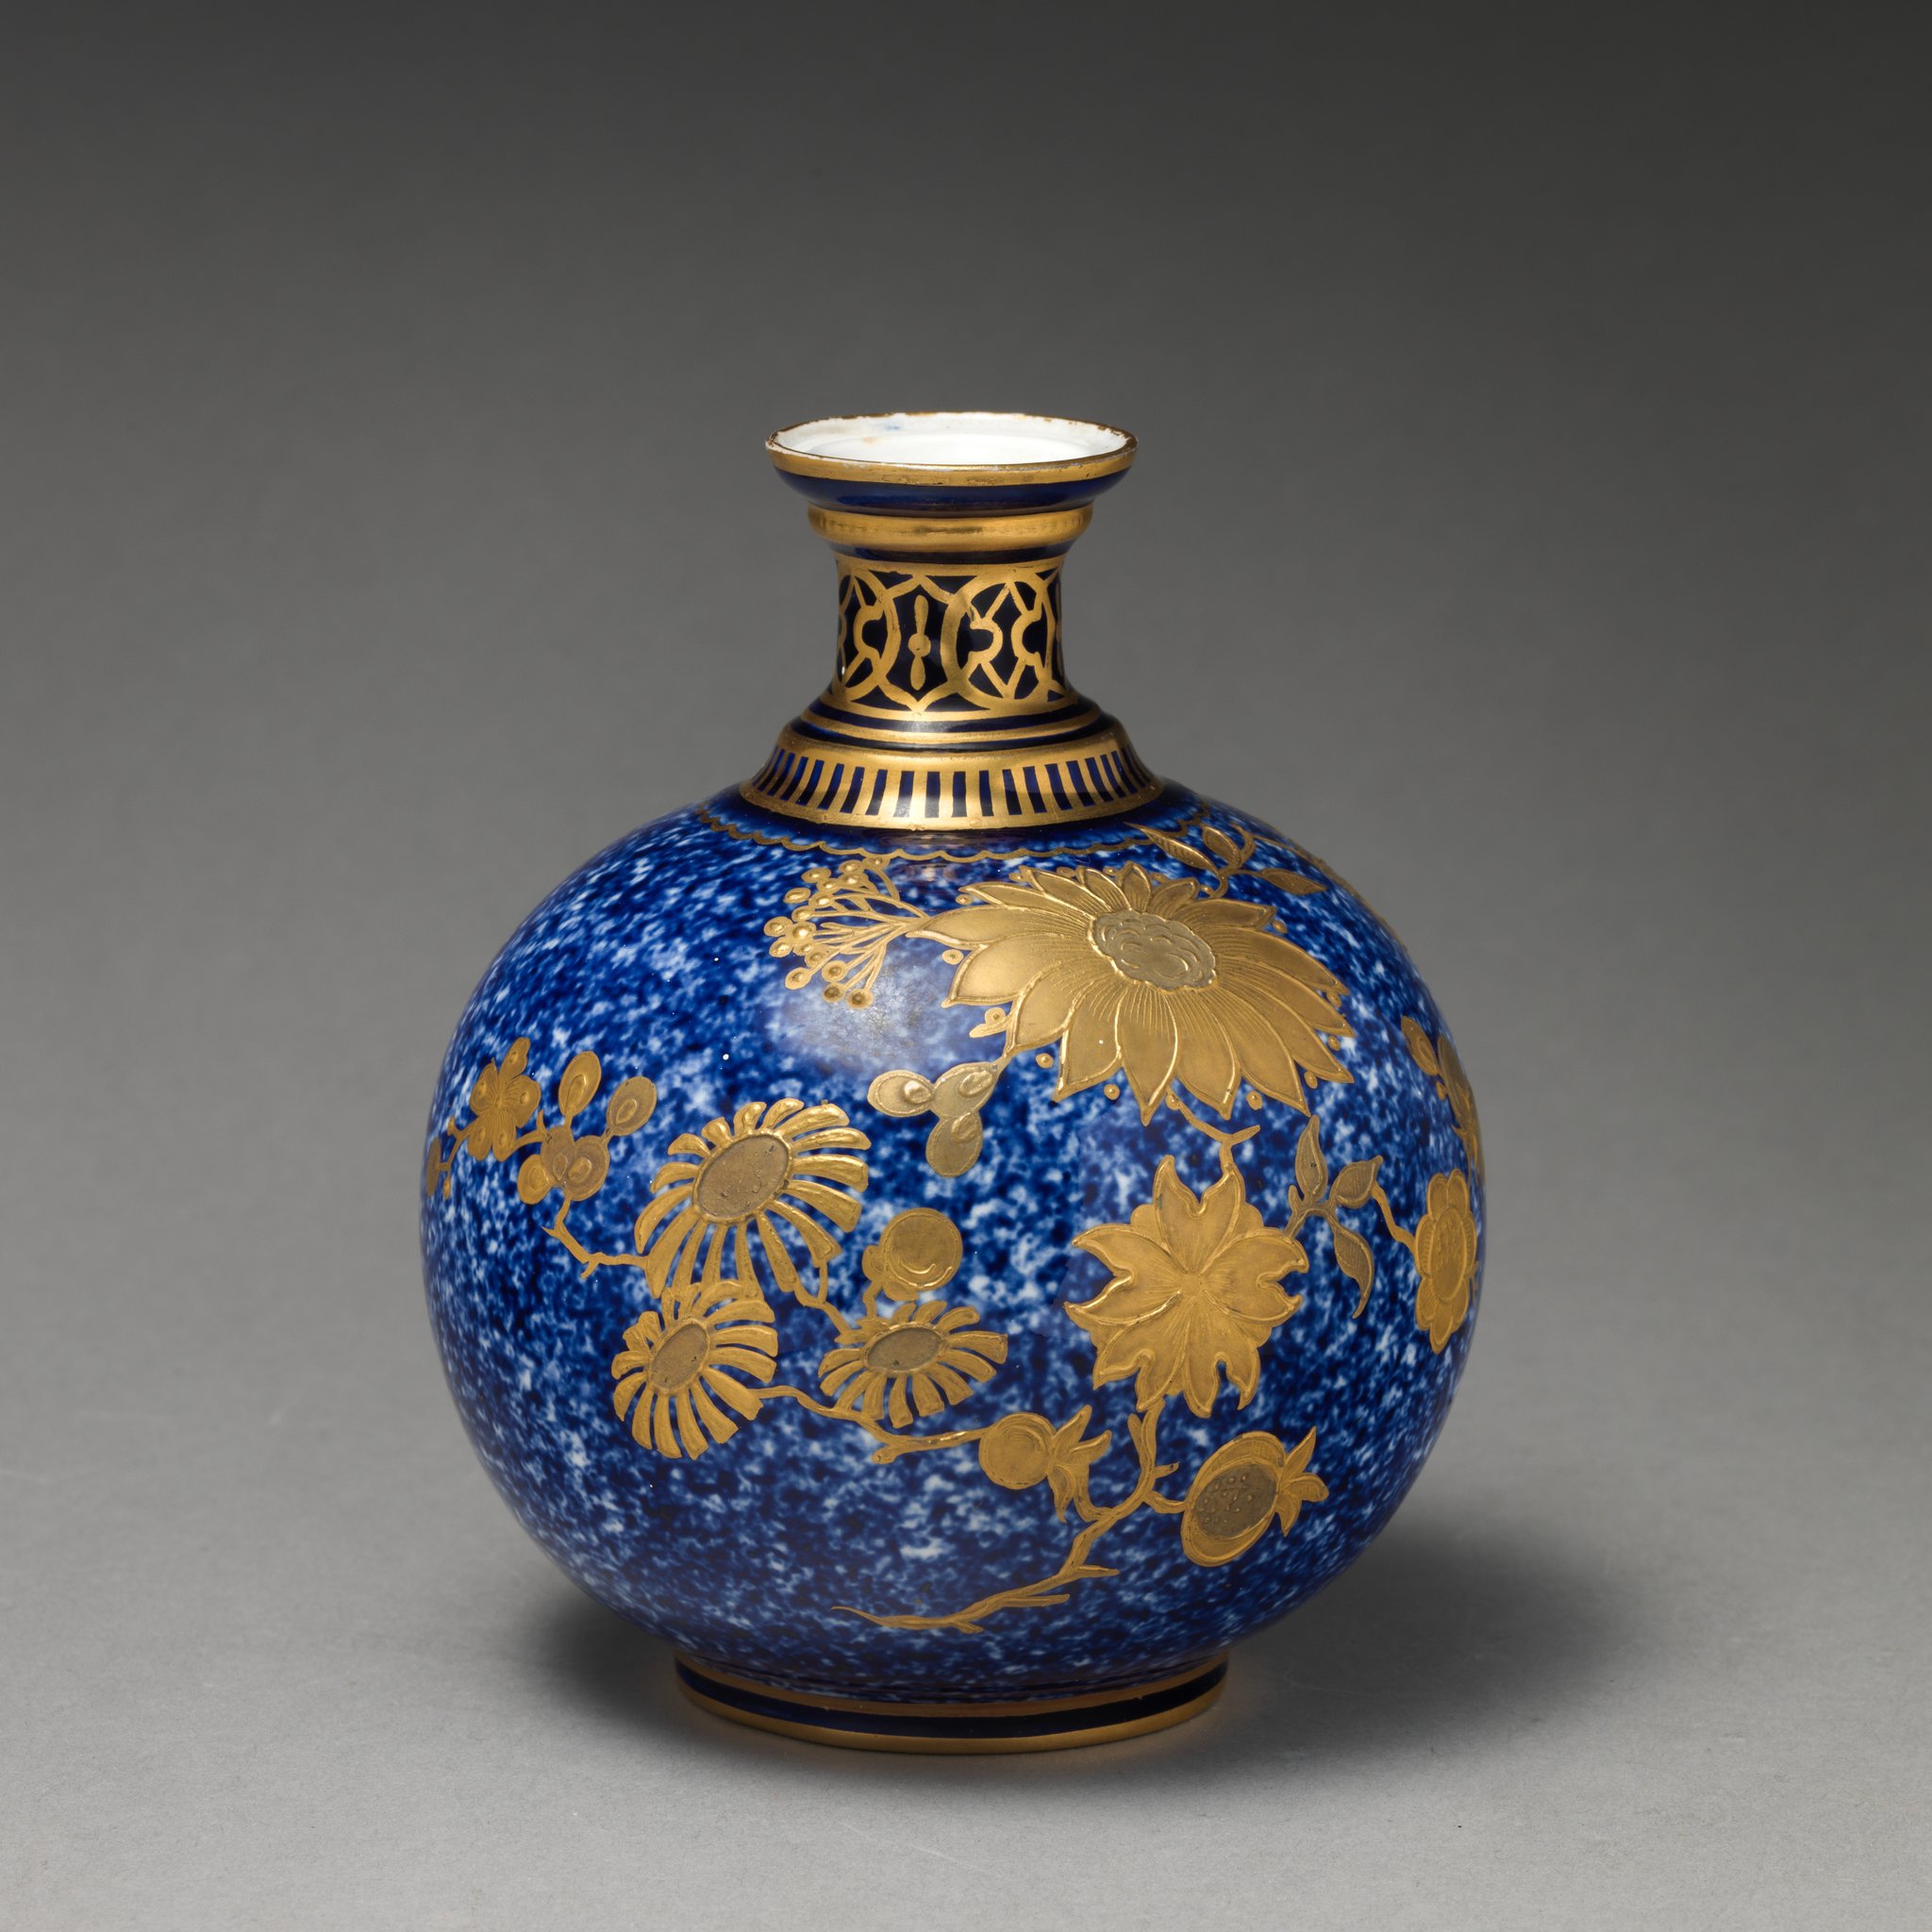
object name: spherical vase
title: Small spherical vase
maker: crown derby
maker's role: maker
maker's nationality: british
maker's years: 1750-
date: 1887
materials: bone china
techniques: gilding